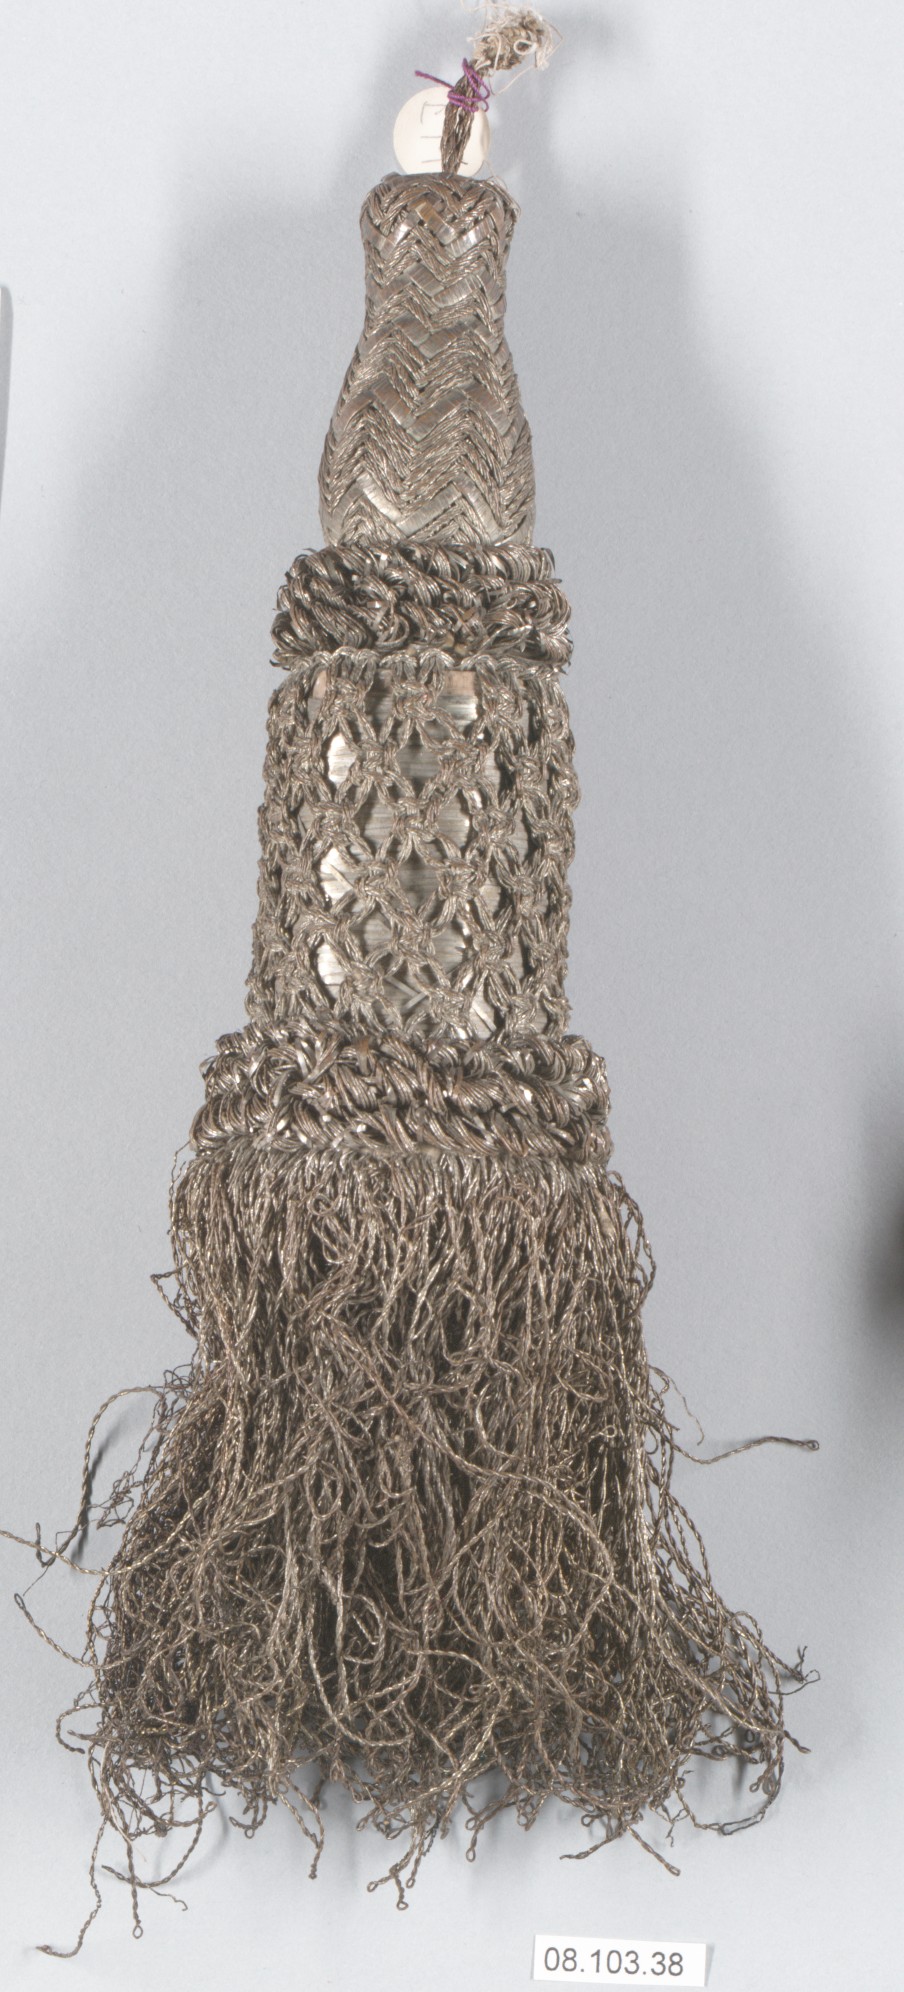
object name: tassel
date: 1601-1700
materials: metal thread